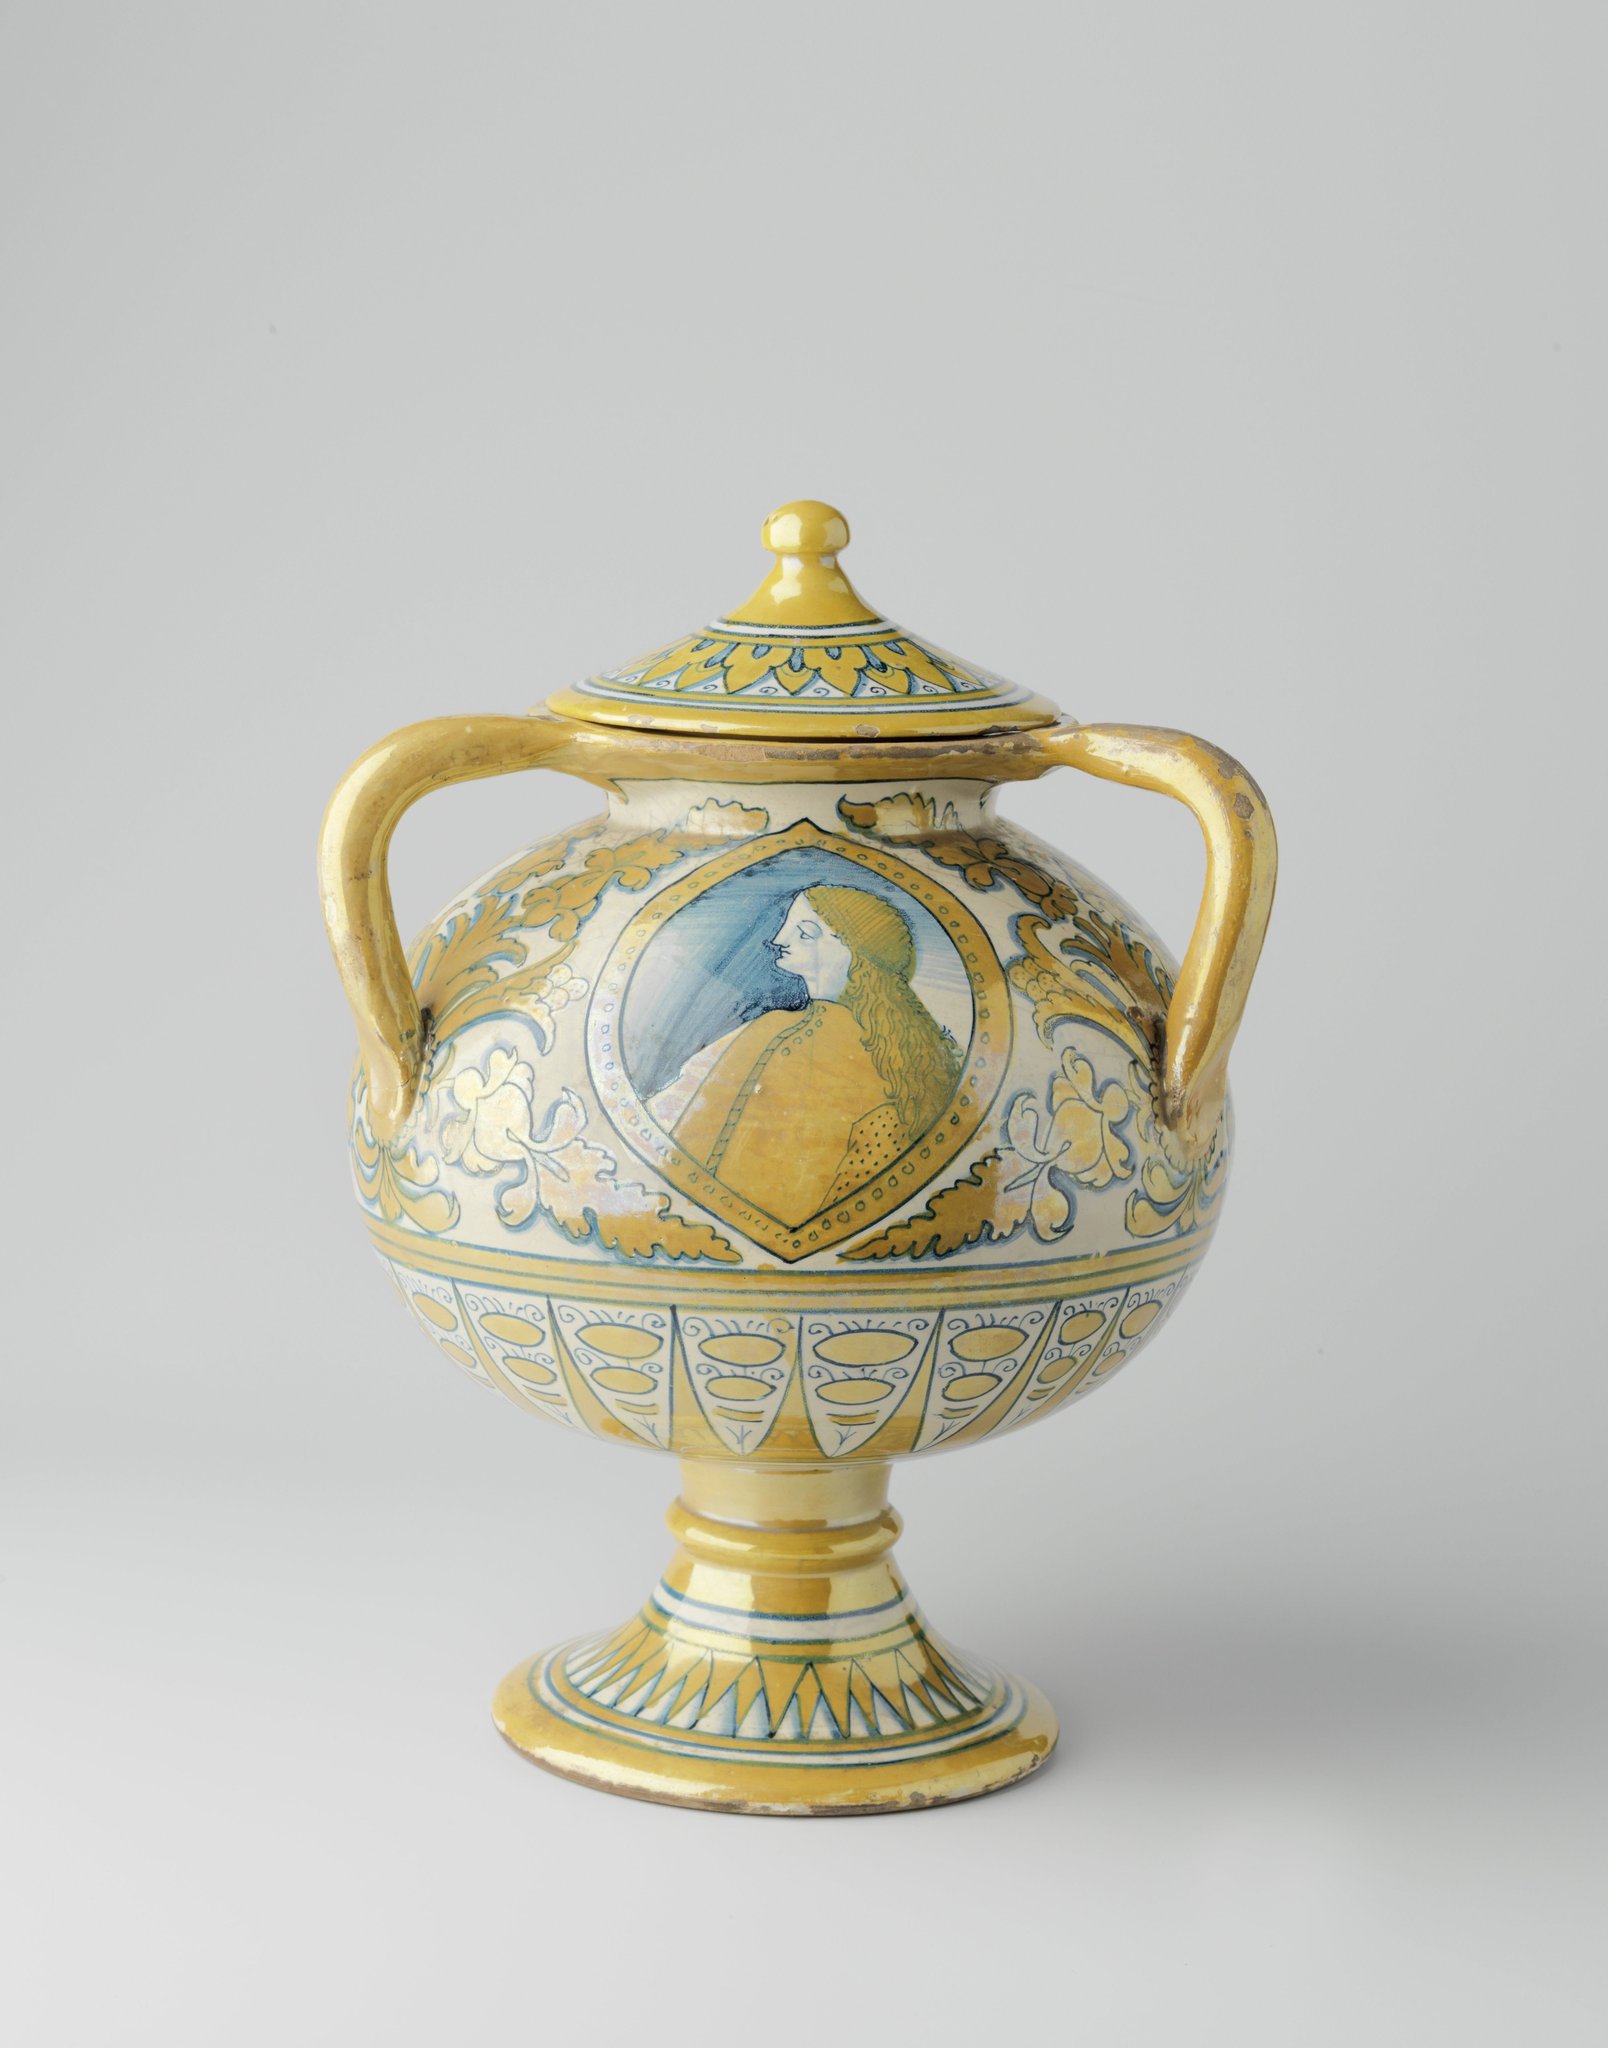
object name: lid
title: Vaas met drie oren en een deksel, veelkleurig beschilderd met spitsovalen waarbinnen mansportretten, en bloem- en bladranken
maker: Anonymous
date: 1510-1525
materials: earthenware, glaze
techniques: maiolica, painted, polychromy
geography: deruta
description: Vase and cover. Maiolica. Deruta, c. 1510 - 1525.